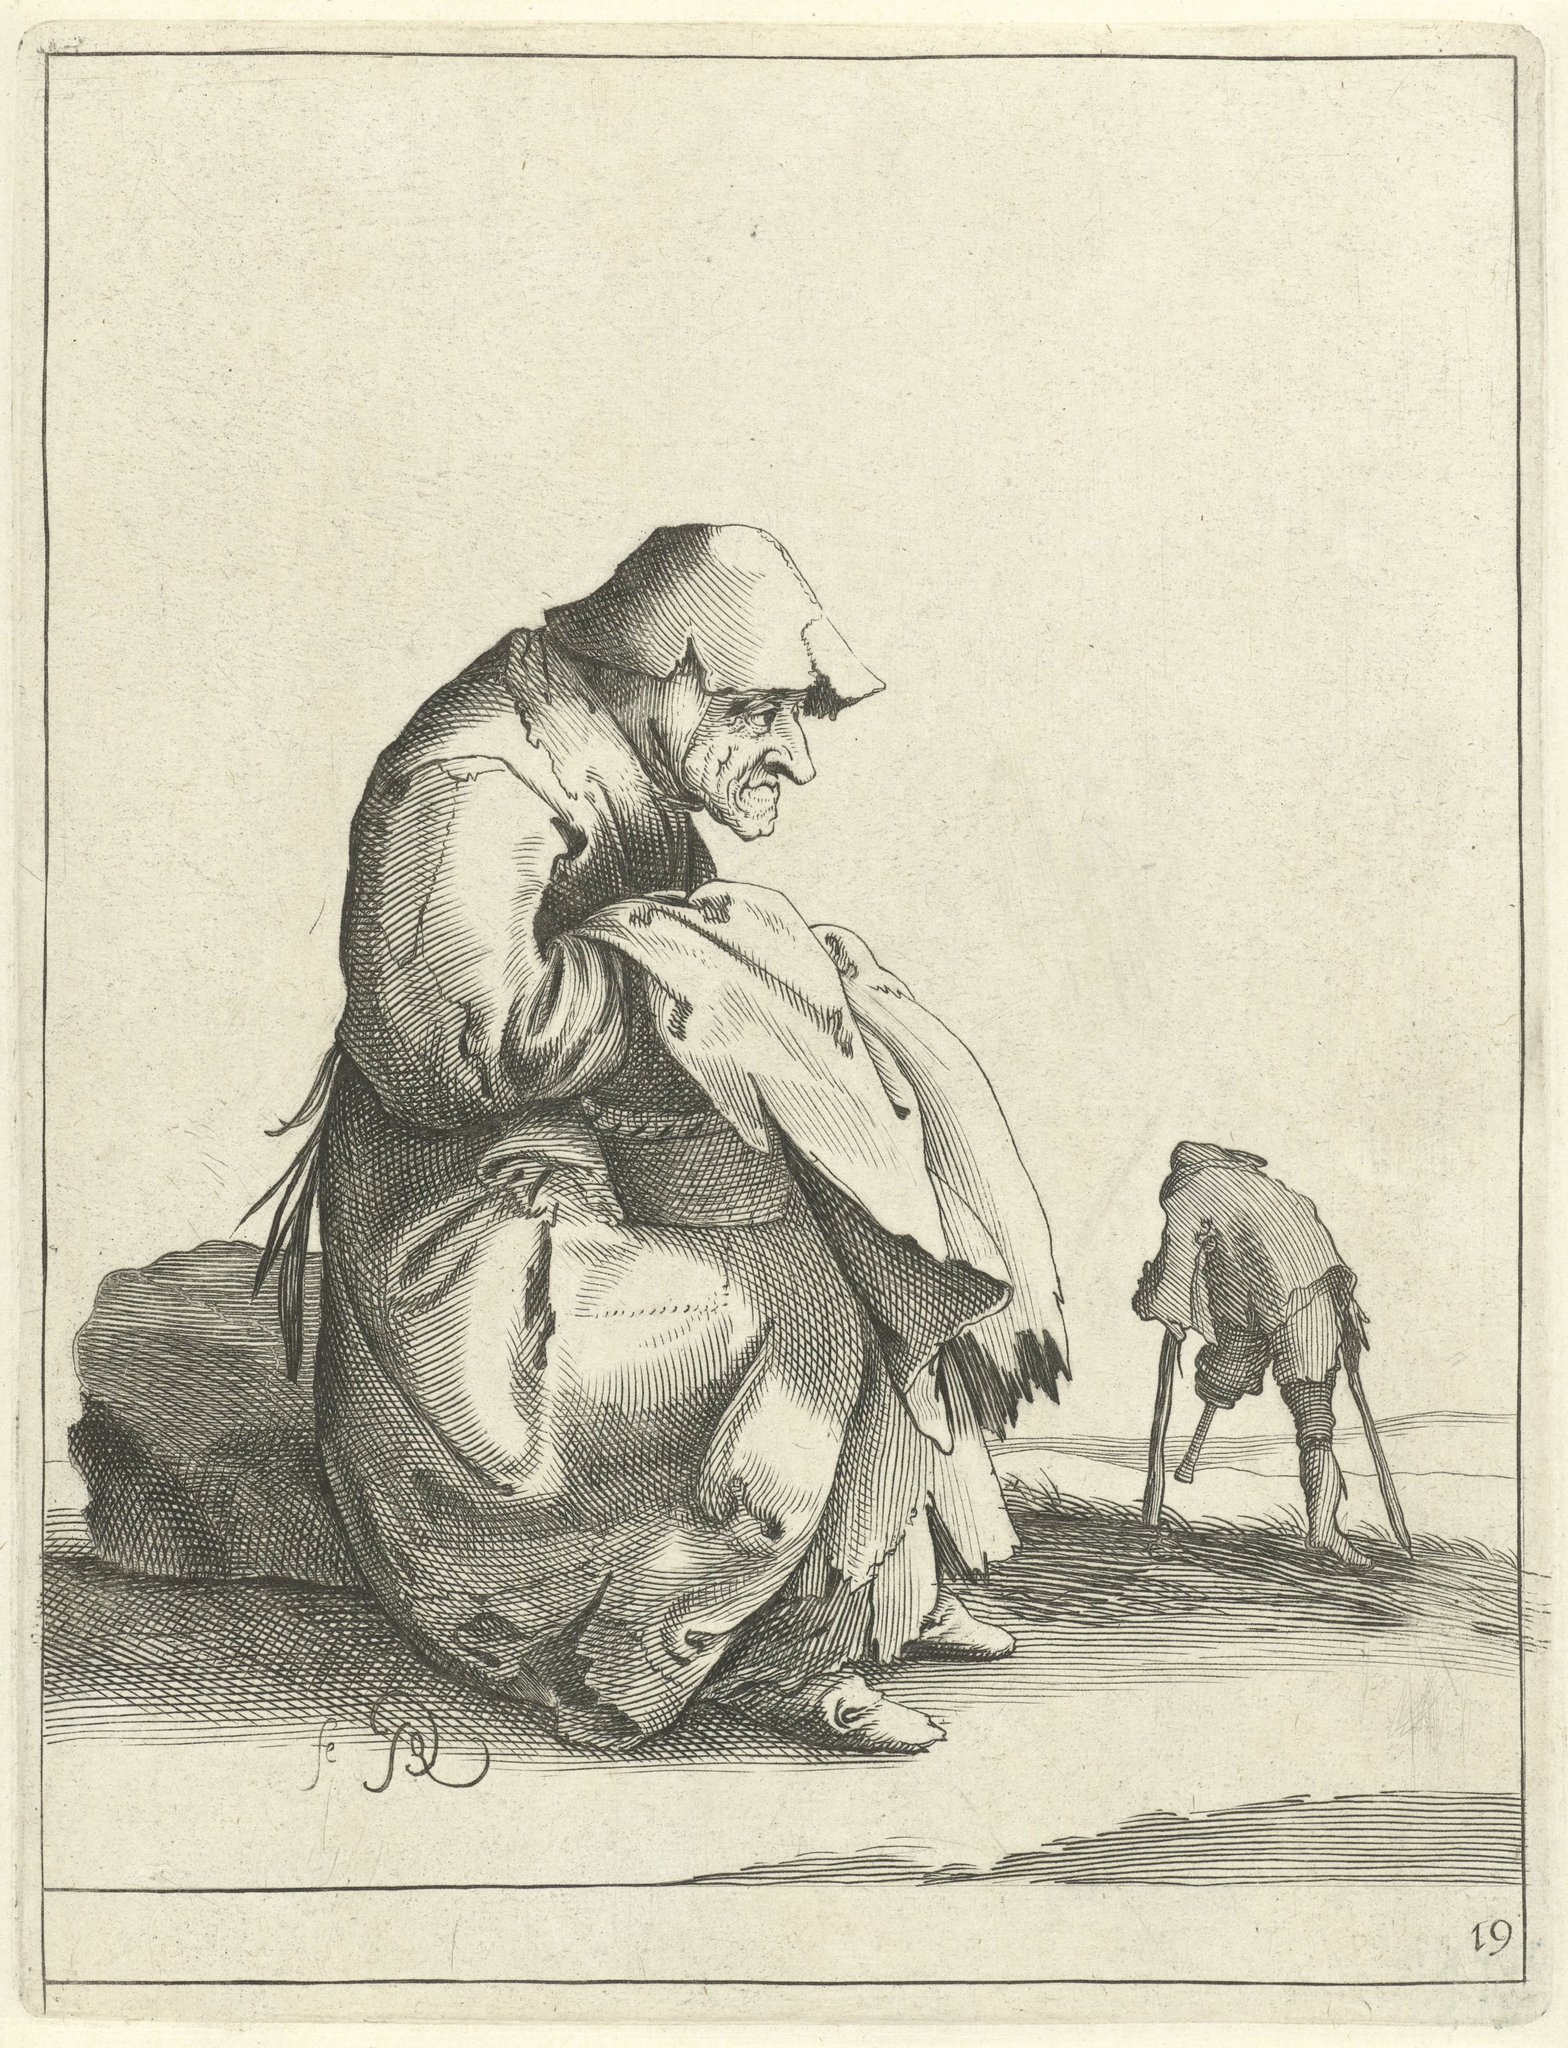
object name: print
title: Bejaarde bedelaarster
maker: pieter jansz quast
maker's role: draughtsman, painter, print maker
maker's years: 1605-1647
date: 1634-1638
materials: paper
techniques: engraving, etching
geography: the hague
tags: crutches, wooden leg, container made of plant material other than wood: basket, beggar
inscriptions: collector's mark: Lugt 2165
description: Op een steen zit een bejaarde bedelaarster met op haar schoot een mand en een doek. Rechts loopt een landloper met een houten been, steunend op krukken. De prent maakt deel uit van een serie van zesentwintig prenten met bedelaars en boeren.